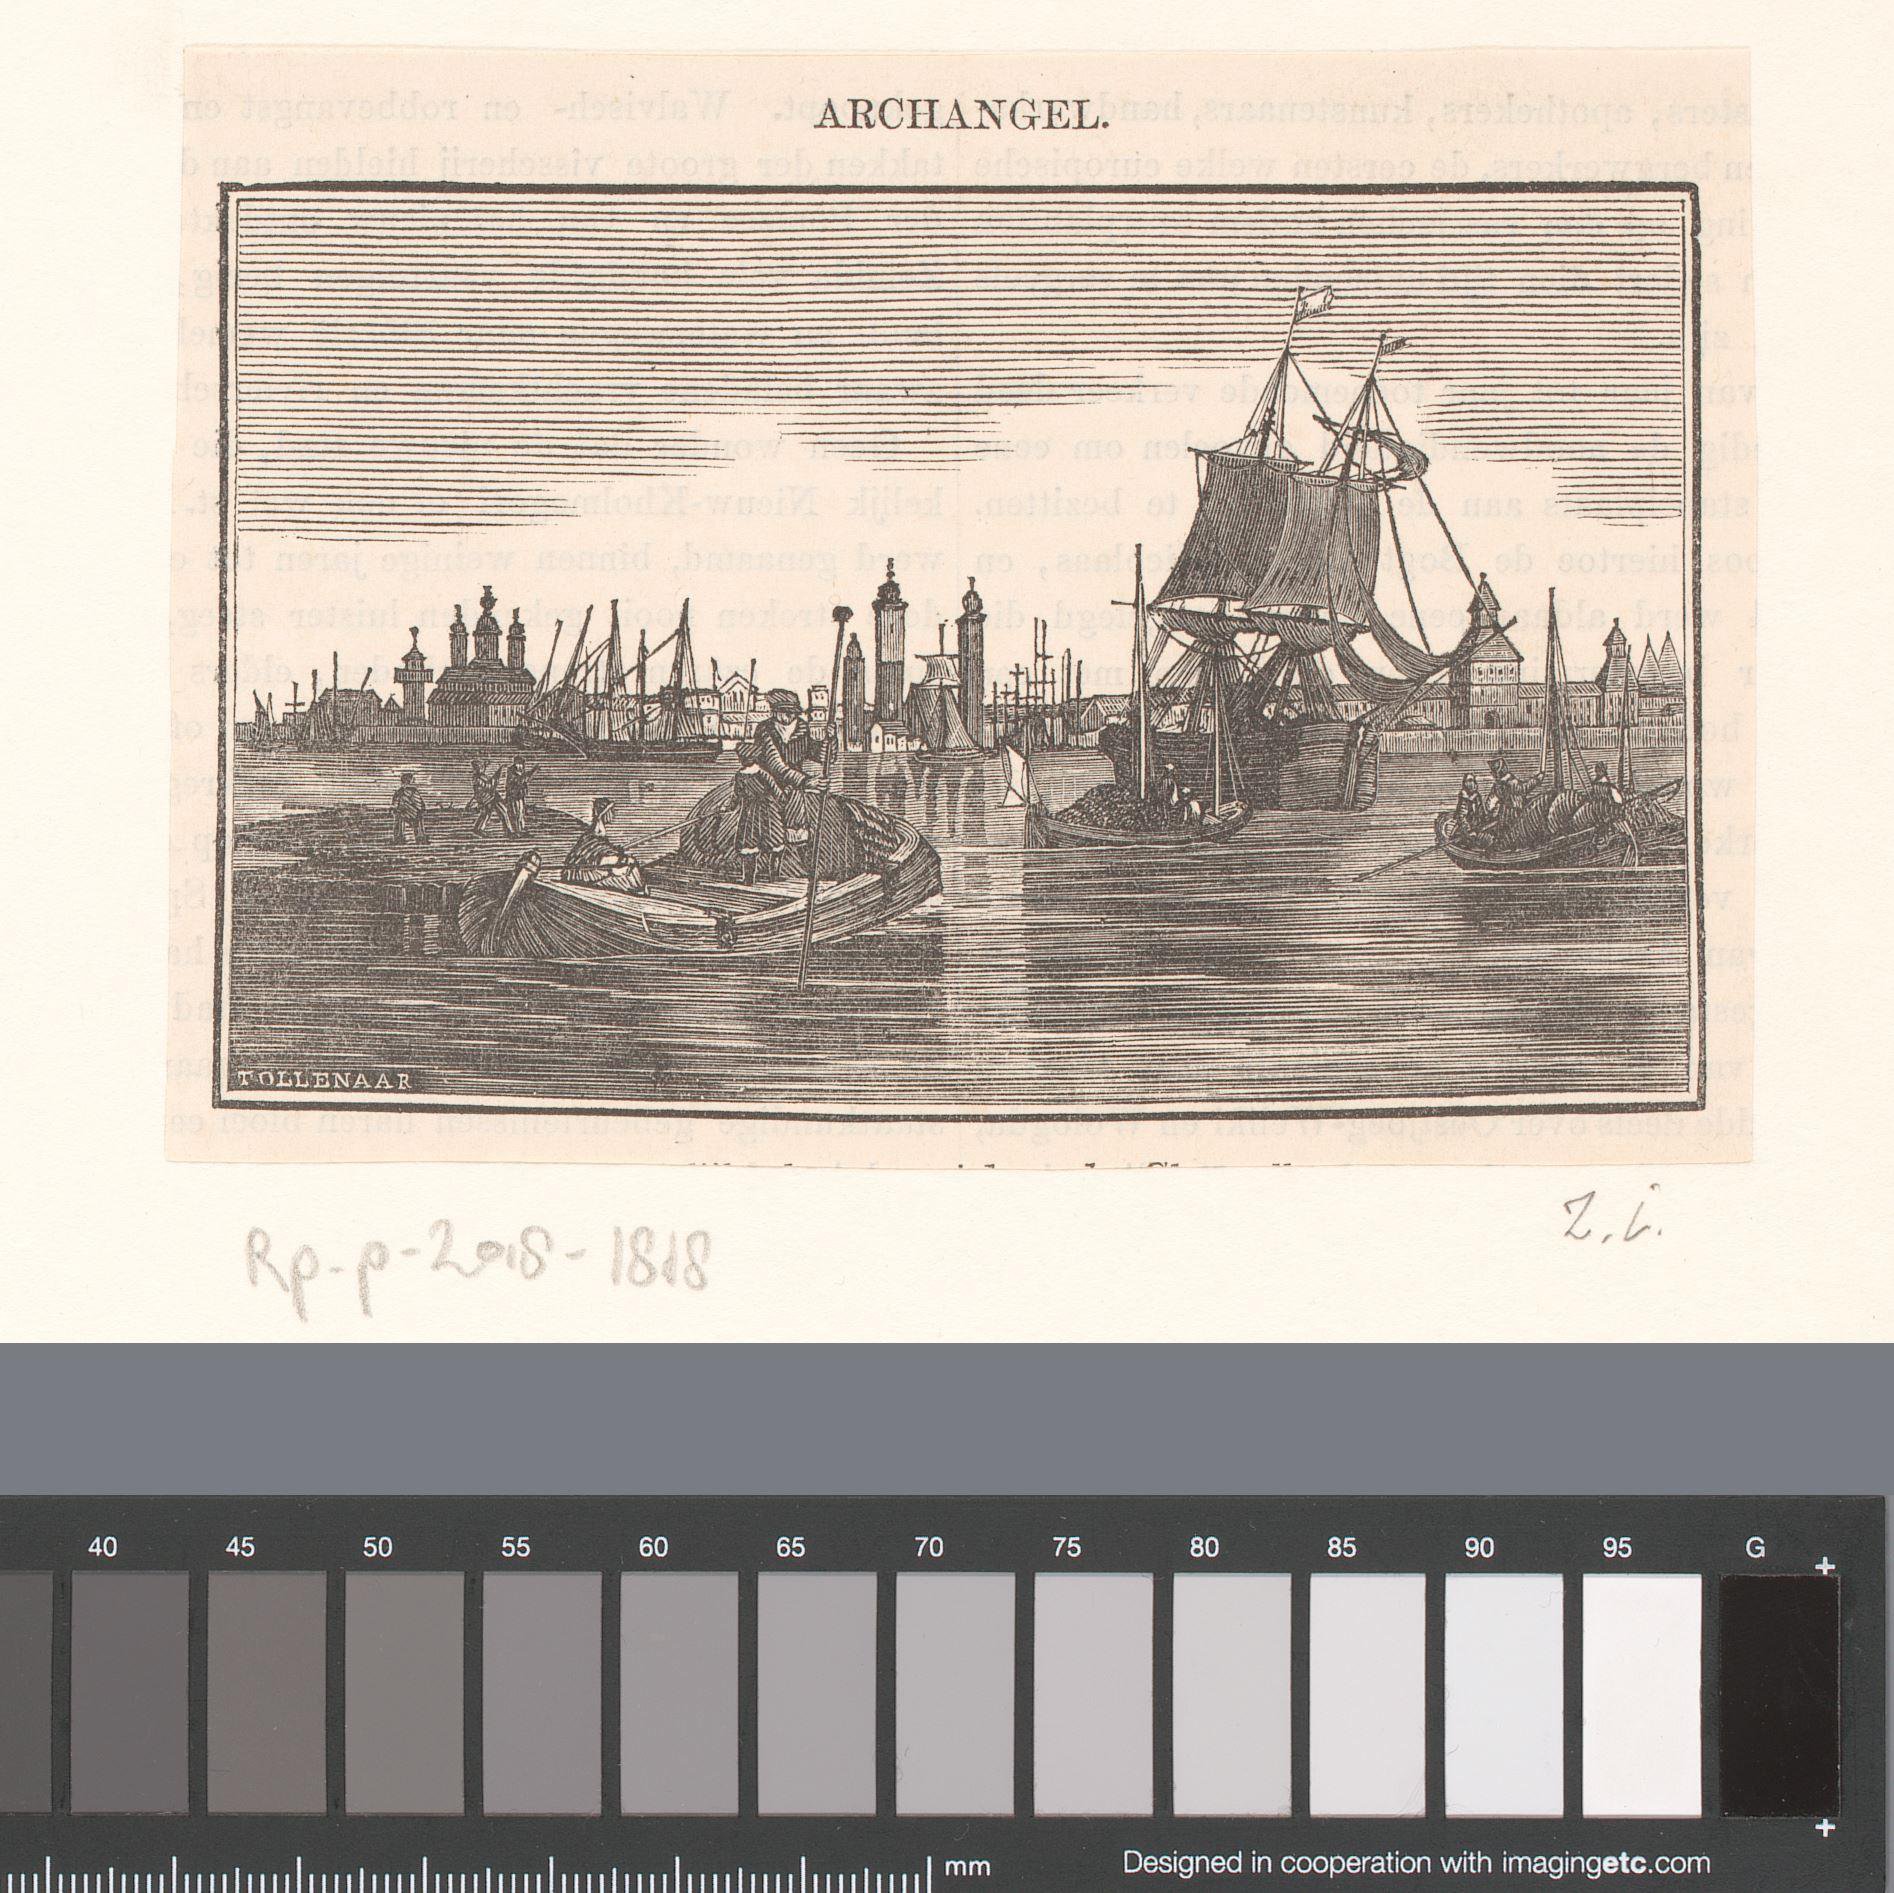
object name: print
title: Archangel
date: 1847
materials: paper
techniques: letterpress printing, engraving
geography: amsterdam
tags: prospect of city, town panorama, silhouette of city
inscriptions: collector's mark: Lugt 2228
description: Prent gebruikt in: Witkamp, P.H. Beschrijving van Oost- en Noord-Europa. Amsterdam: J.H. Laarman, 1847.